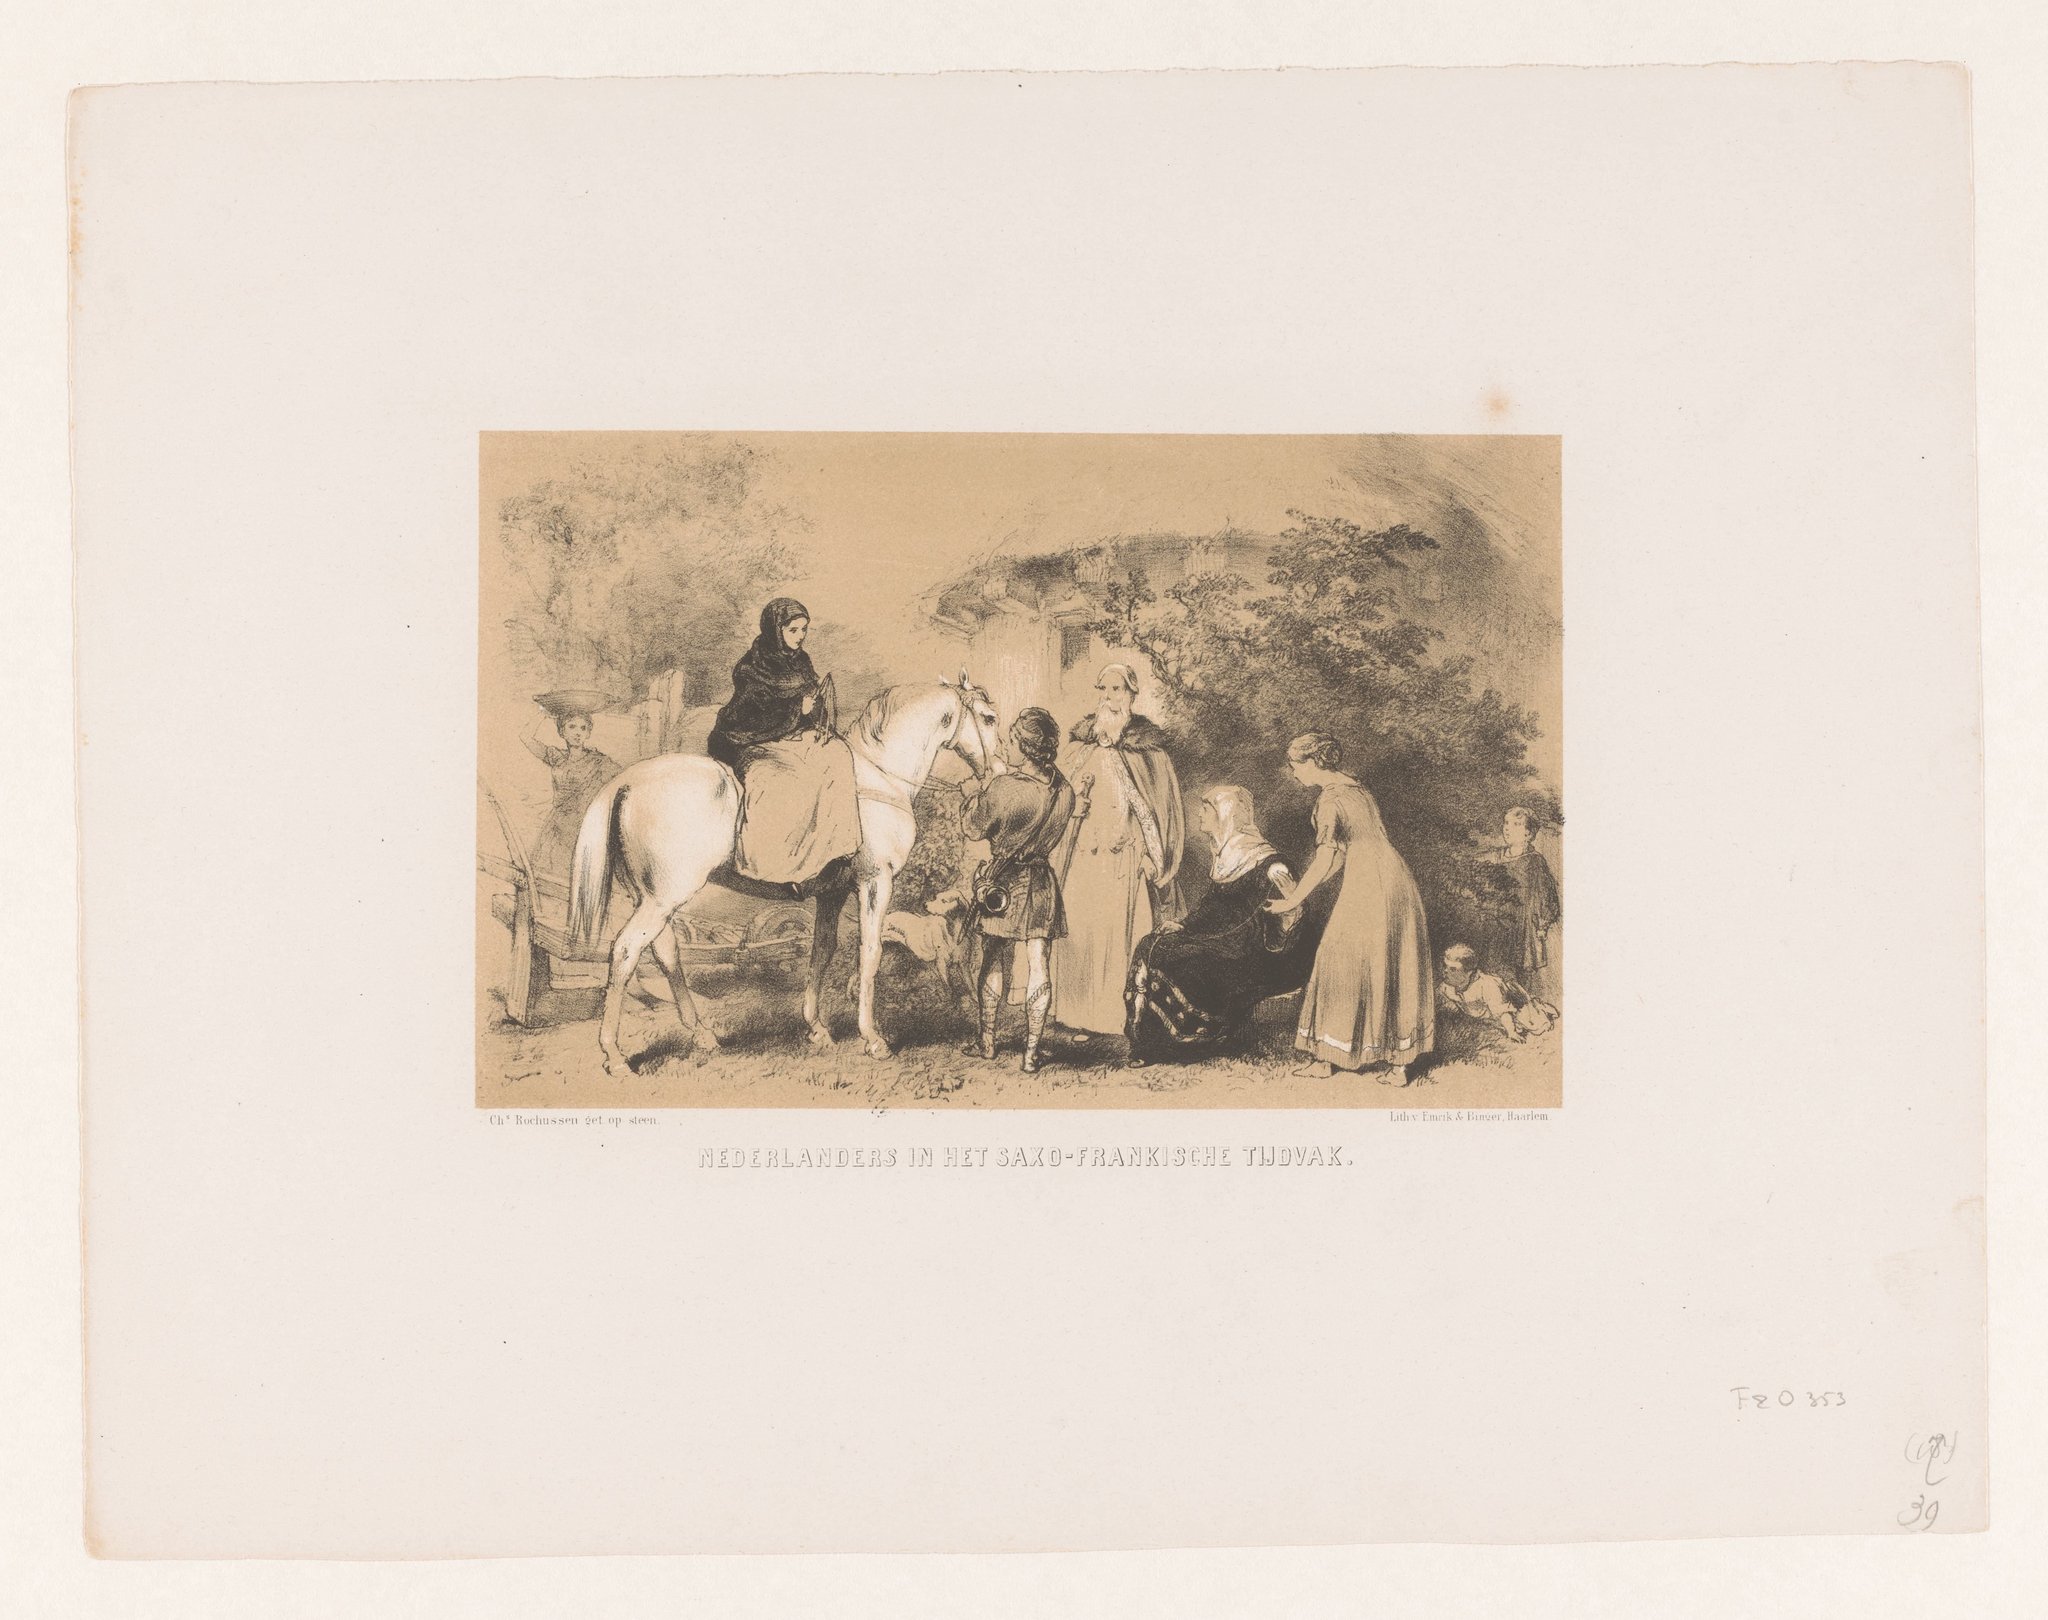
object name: book illustration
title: Vrouw te paard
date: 1858-1864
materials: paper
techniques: tone lithography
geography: haarlem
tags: riding a horse, ass, or mule; rider, horseman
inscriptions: collector's mark: Lugt 2228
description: Een vrouw te paard tegenover een oude man en vrouw. Bij het paard staat een jongeman. Rechts een jonge vrouw en twee kinderen.